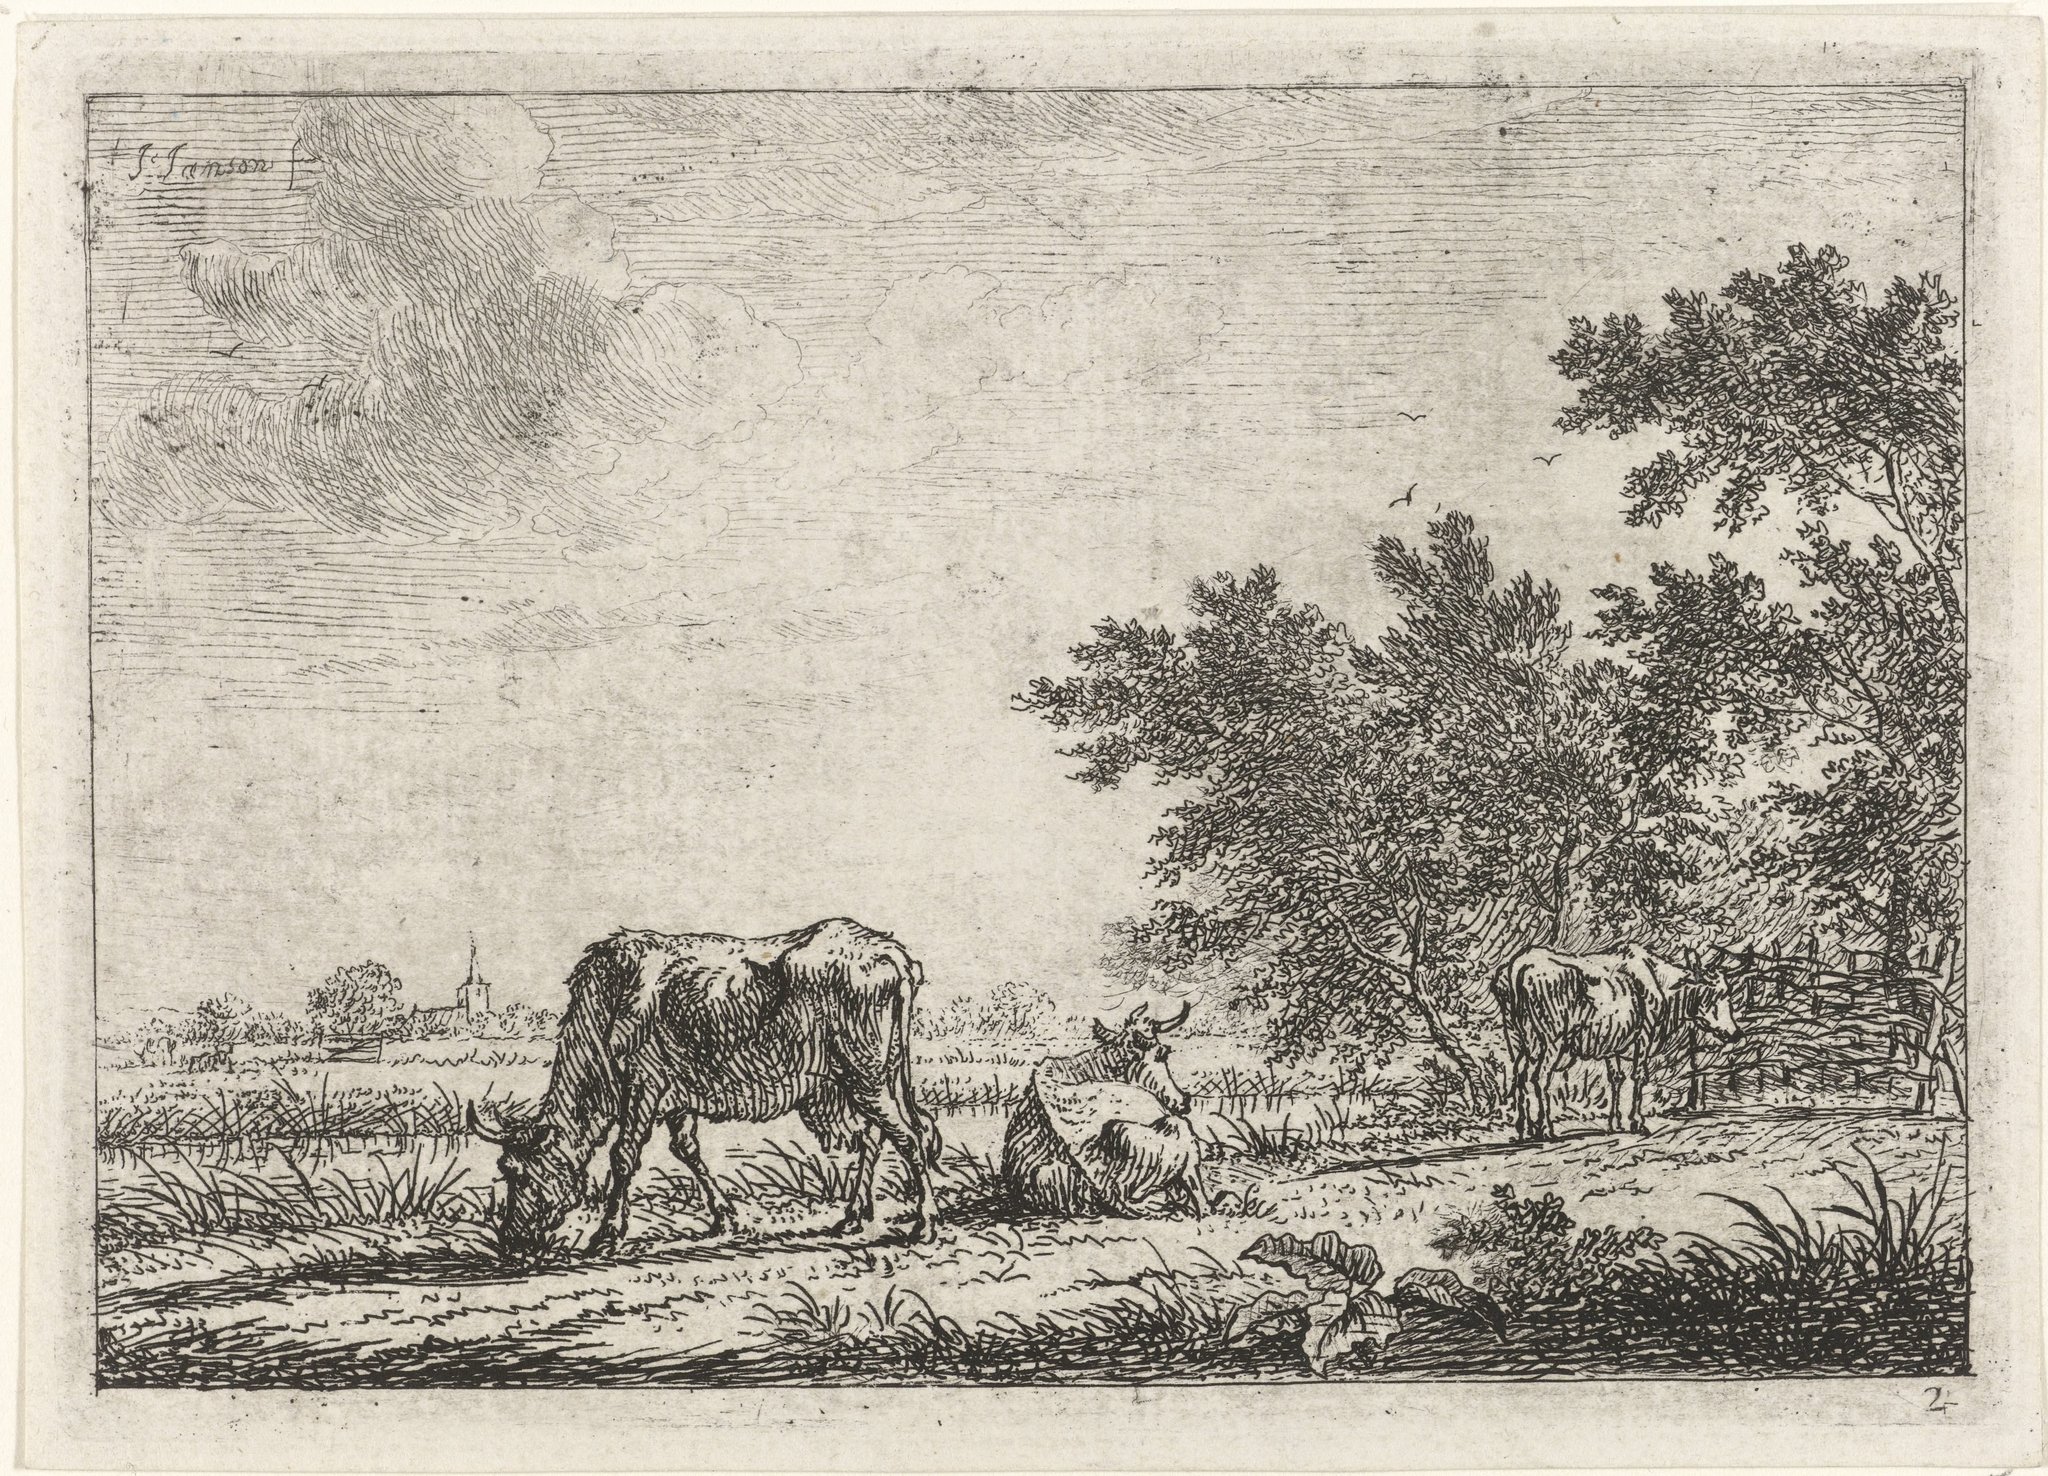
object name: print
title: Drie koeien in weiland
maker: johannes janson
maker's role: draughtsman, painter, print maker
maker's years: 1729-1784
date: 1761-1784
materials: paper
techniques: etching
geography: leiden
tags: cow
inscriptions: collector's mark: Lugt 2228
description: Weiland met drie koeien, één staat bij een hek. Tweede prent uit een serie van acht met landschappen met vee.